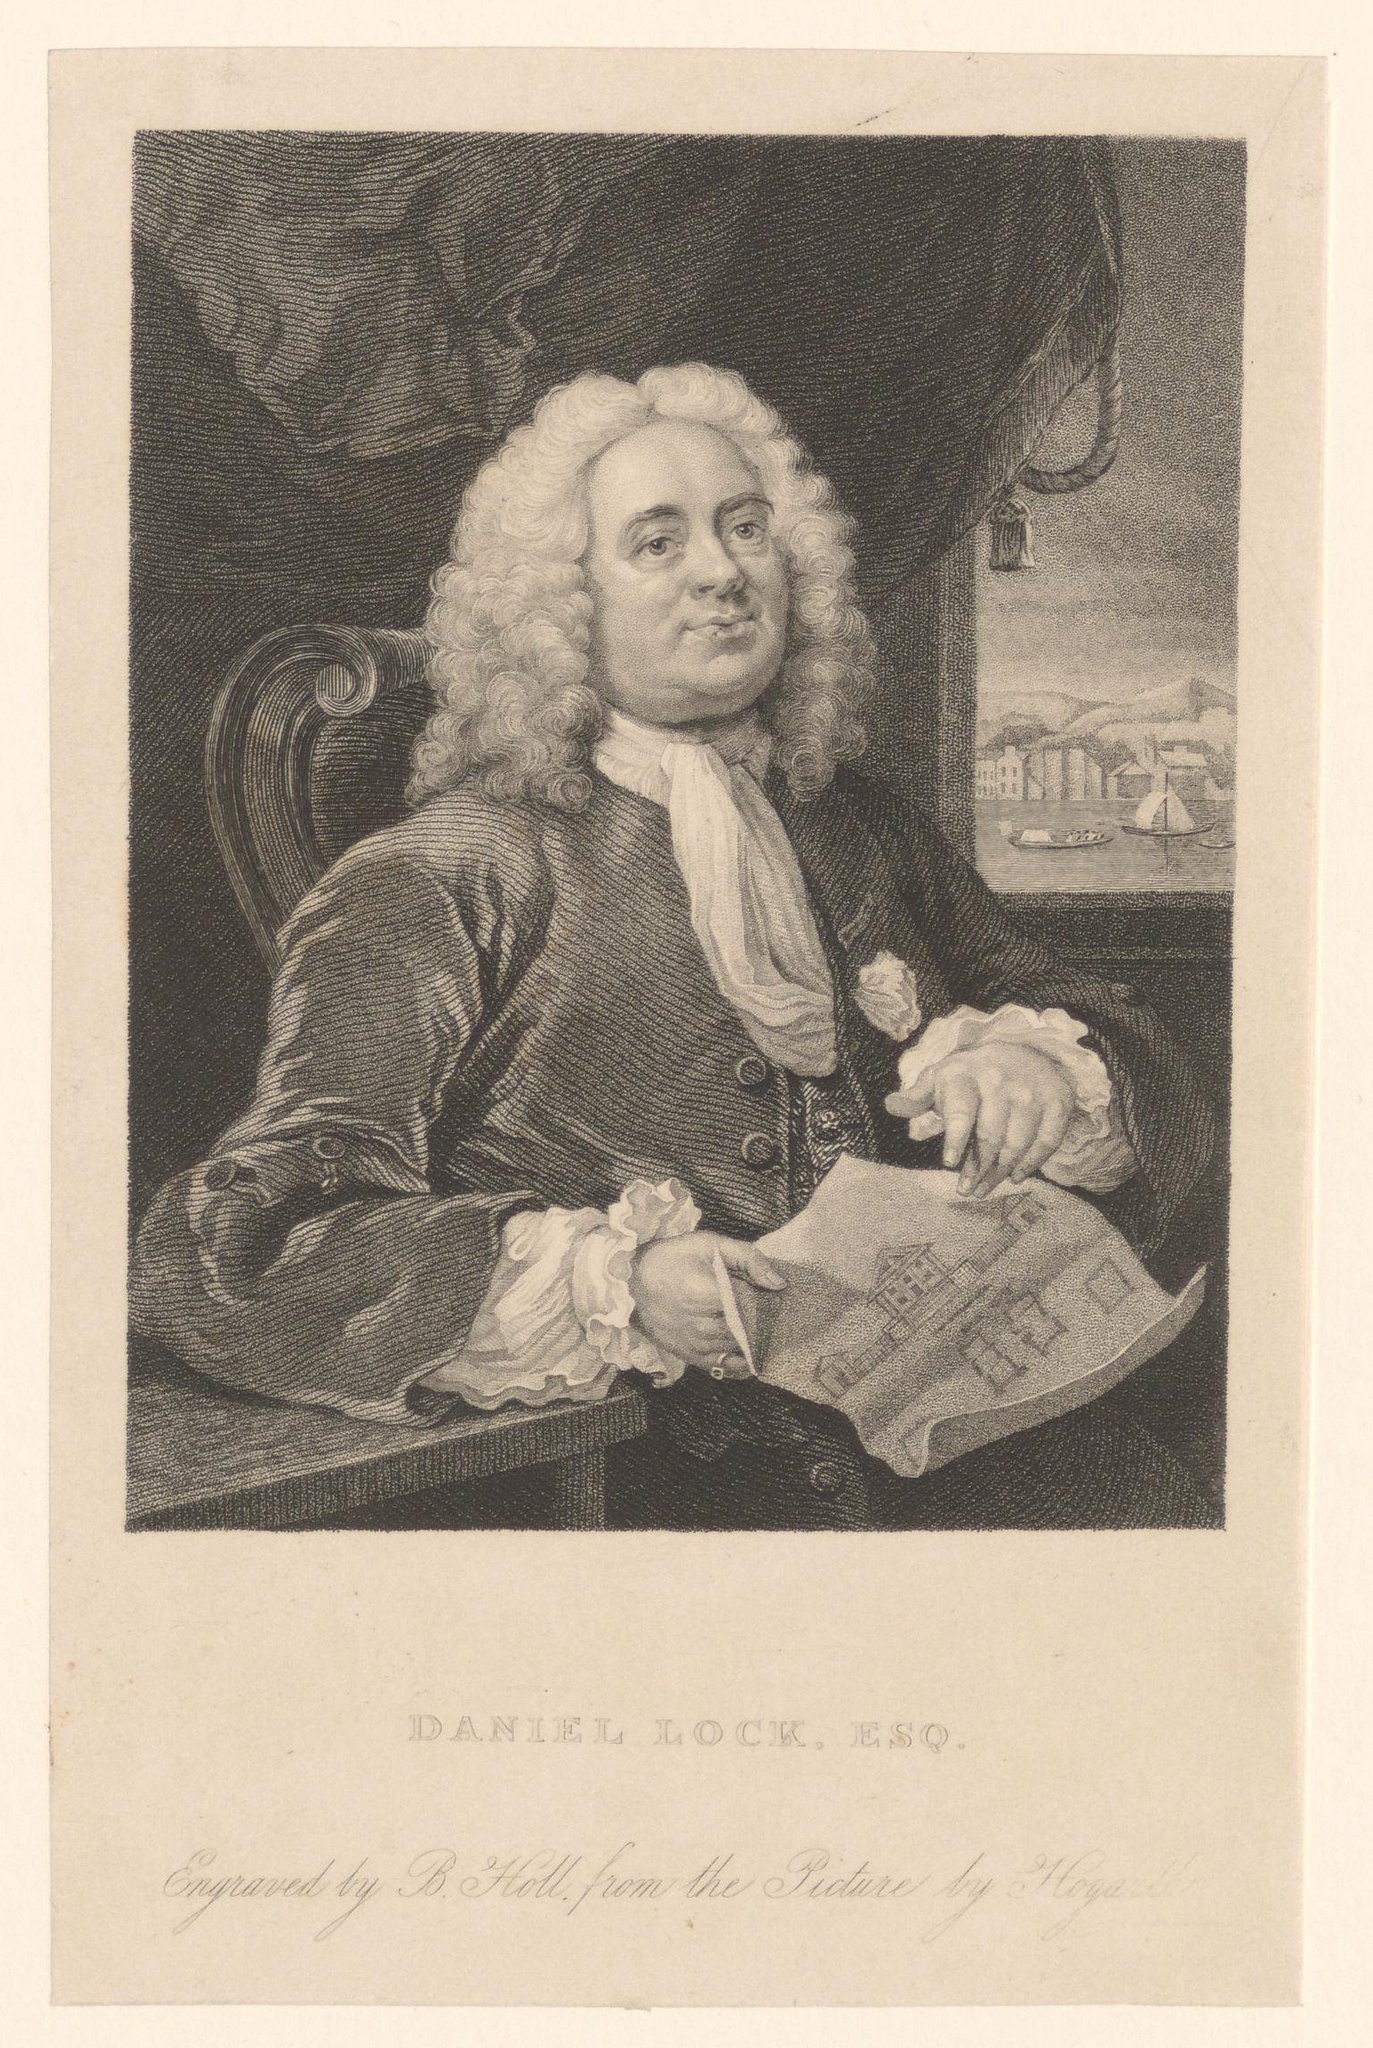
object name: print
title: Portret van Daniel Lock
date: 1828-1836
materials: paper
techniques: etching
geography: london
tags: historical persons, portrait, self-portrait of architect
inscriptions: collector's mark: Lugt 2228